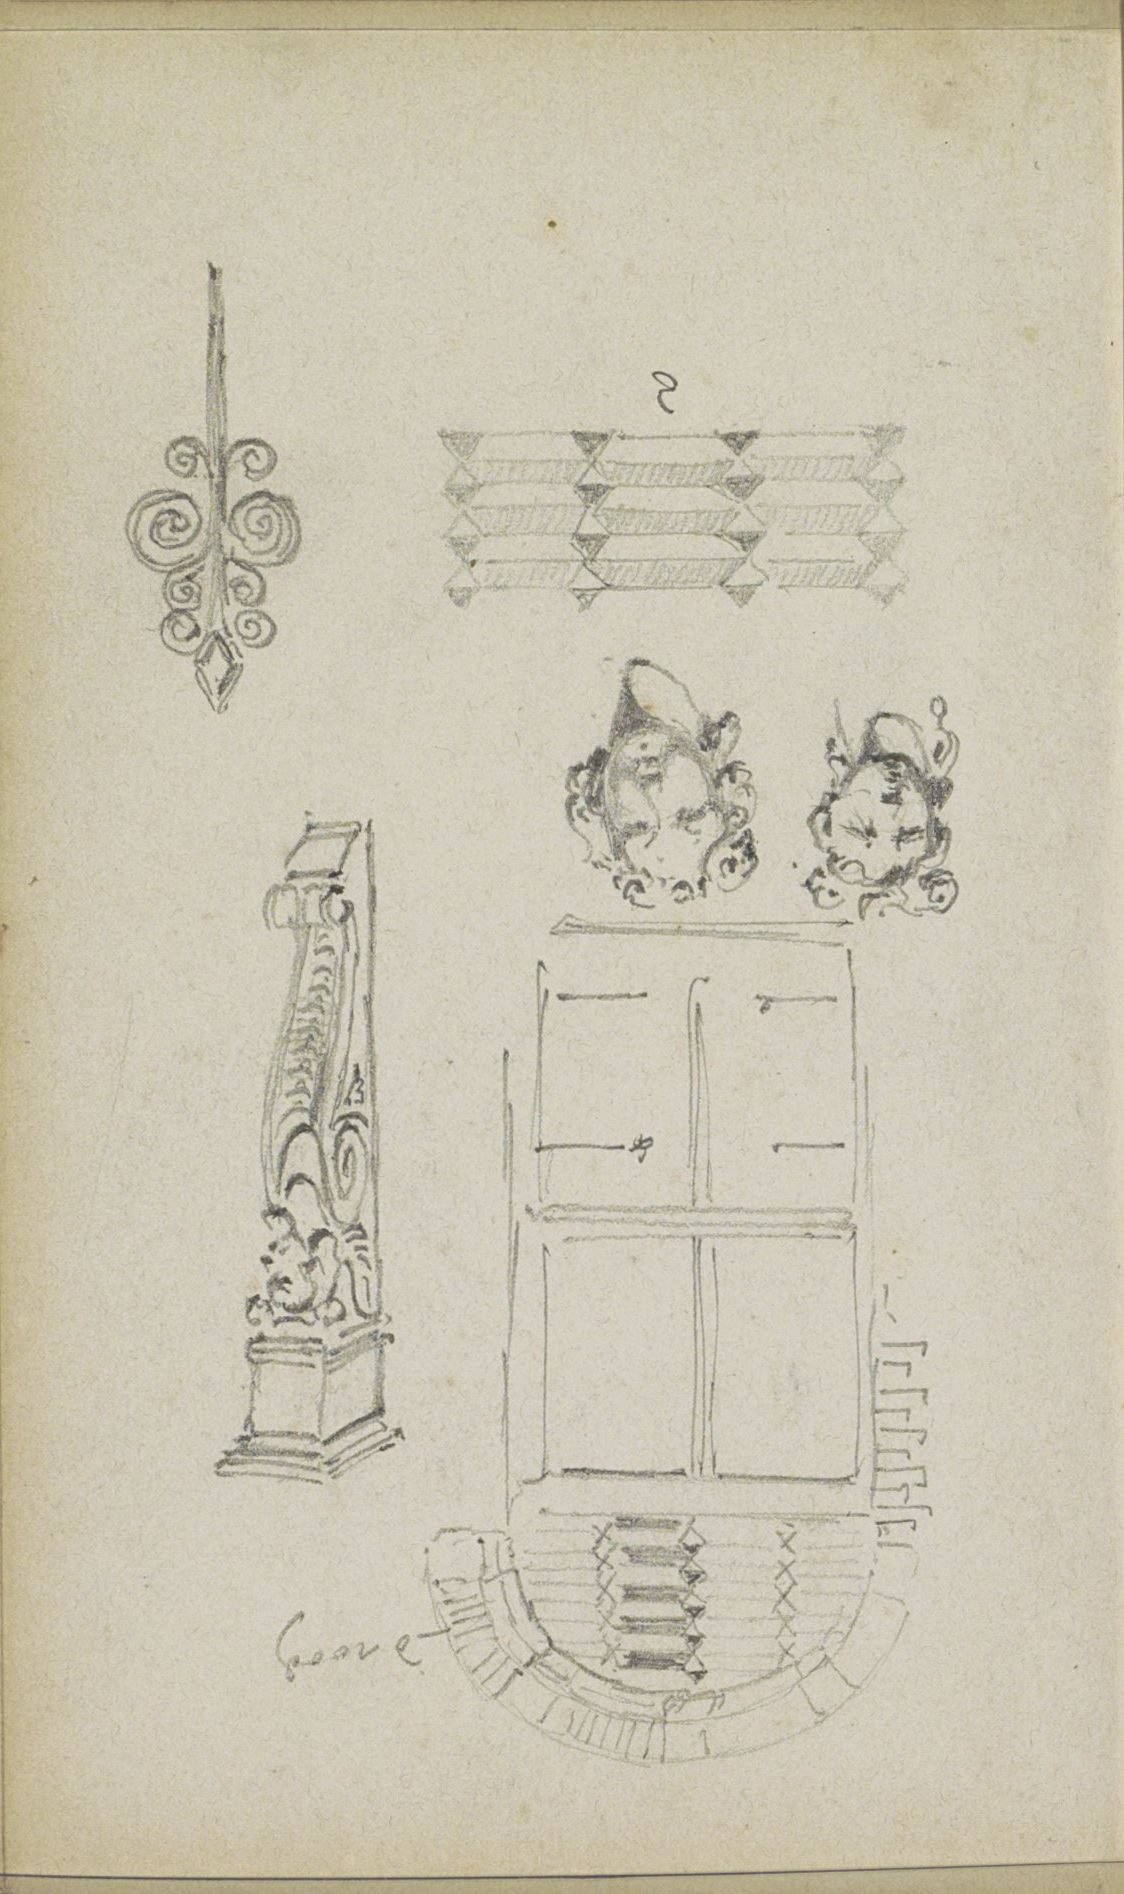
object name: sketchbook leaf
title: Architectuurstudies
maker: adrianus eversen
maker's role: draughtsman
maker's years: 1818-1897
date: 1828-1897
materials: paper, pencil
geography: netherlands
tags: window shutters, architectural detail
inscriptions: inscription: ‘droog’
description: Architectuurstudies. Een rondboog met een raam met gesloten luiken. Verder een console met een gevleugelde figuur. Onder het raam twee gebeeldhouwde hoofden. Ook een metselverband en een muuranker. Blad 51 verso uit een schetsboek met 69 bladen vervaardigd in de omgeving van Delft, Rotterdam, Oudewater en Harlingen.